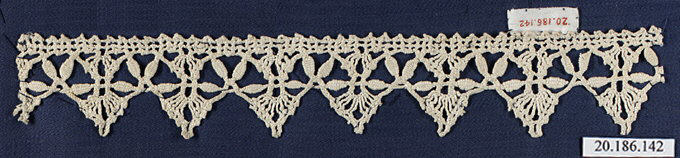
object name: edging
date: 1601-1700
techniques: lace